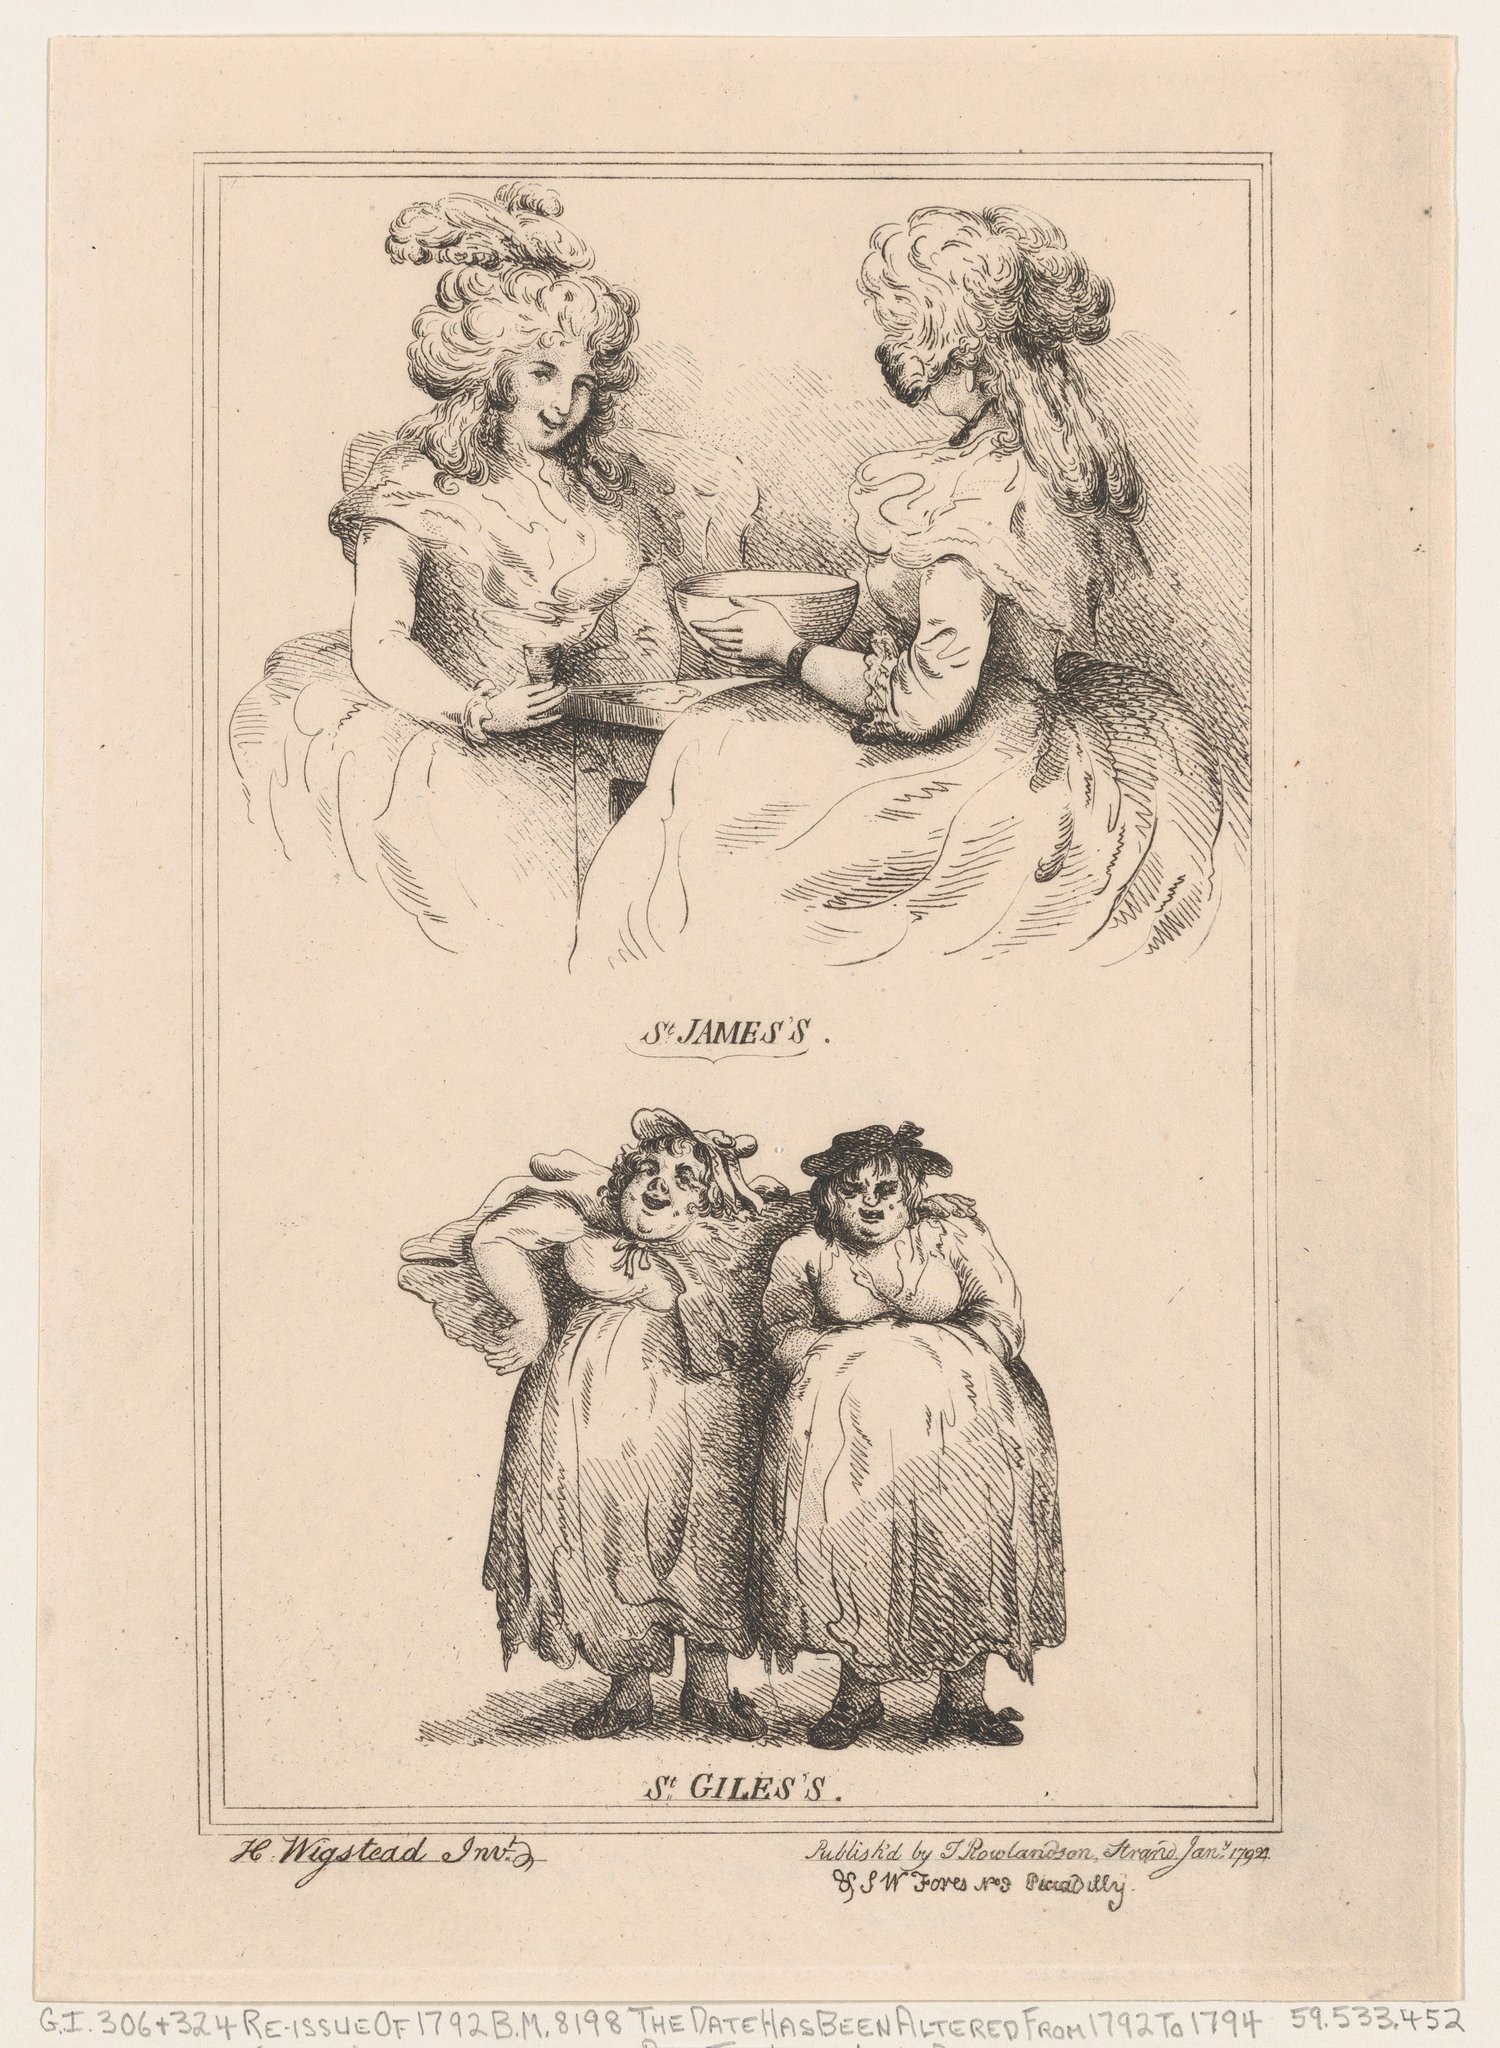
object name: print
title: St James's and St Giles's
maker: thomas rowlandson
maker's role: artist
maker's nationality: british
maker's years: 1757-1827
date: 1792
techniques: etching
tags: satire,women